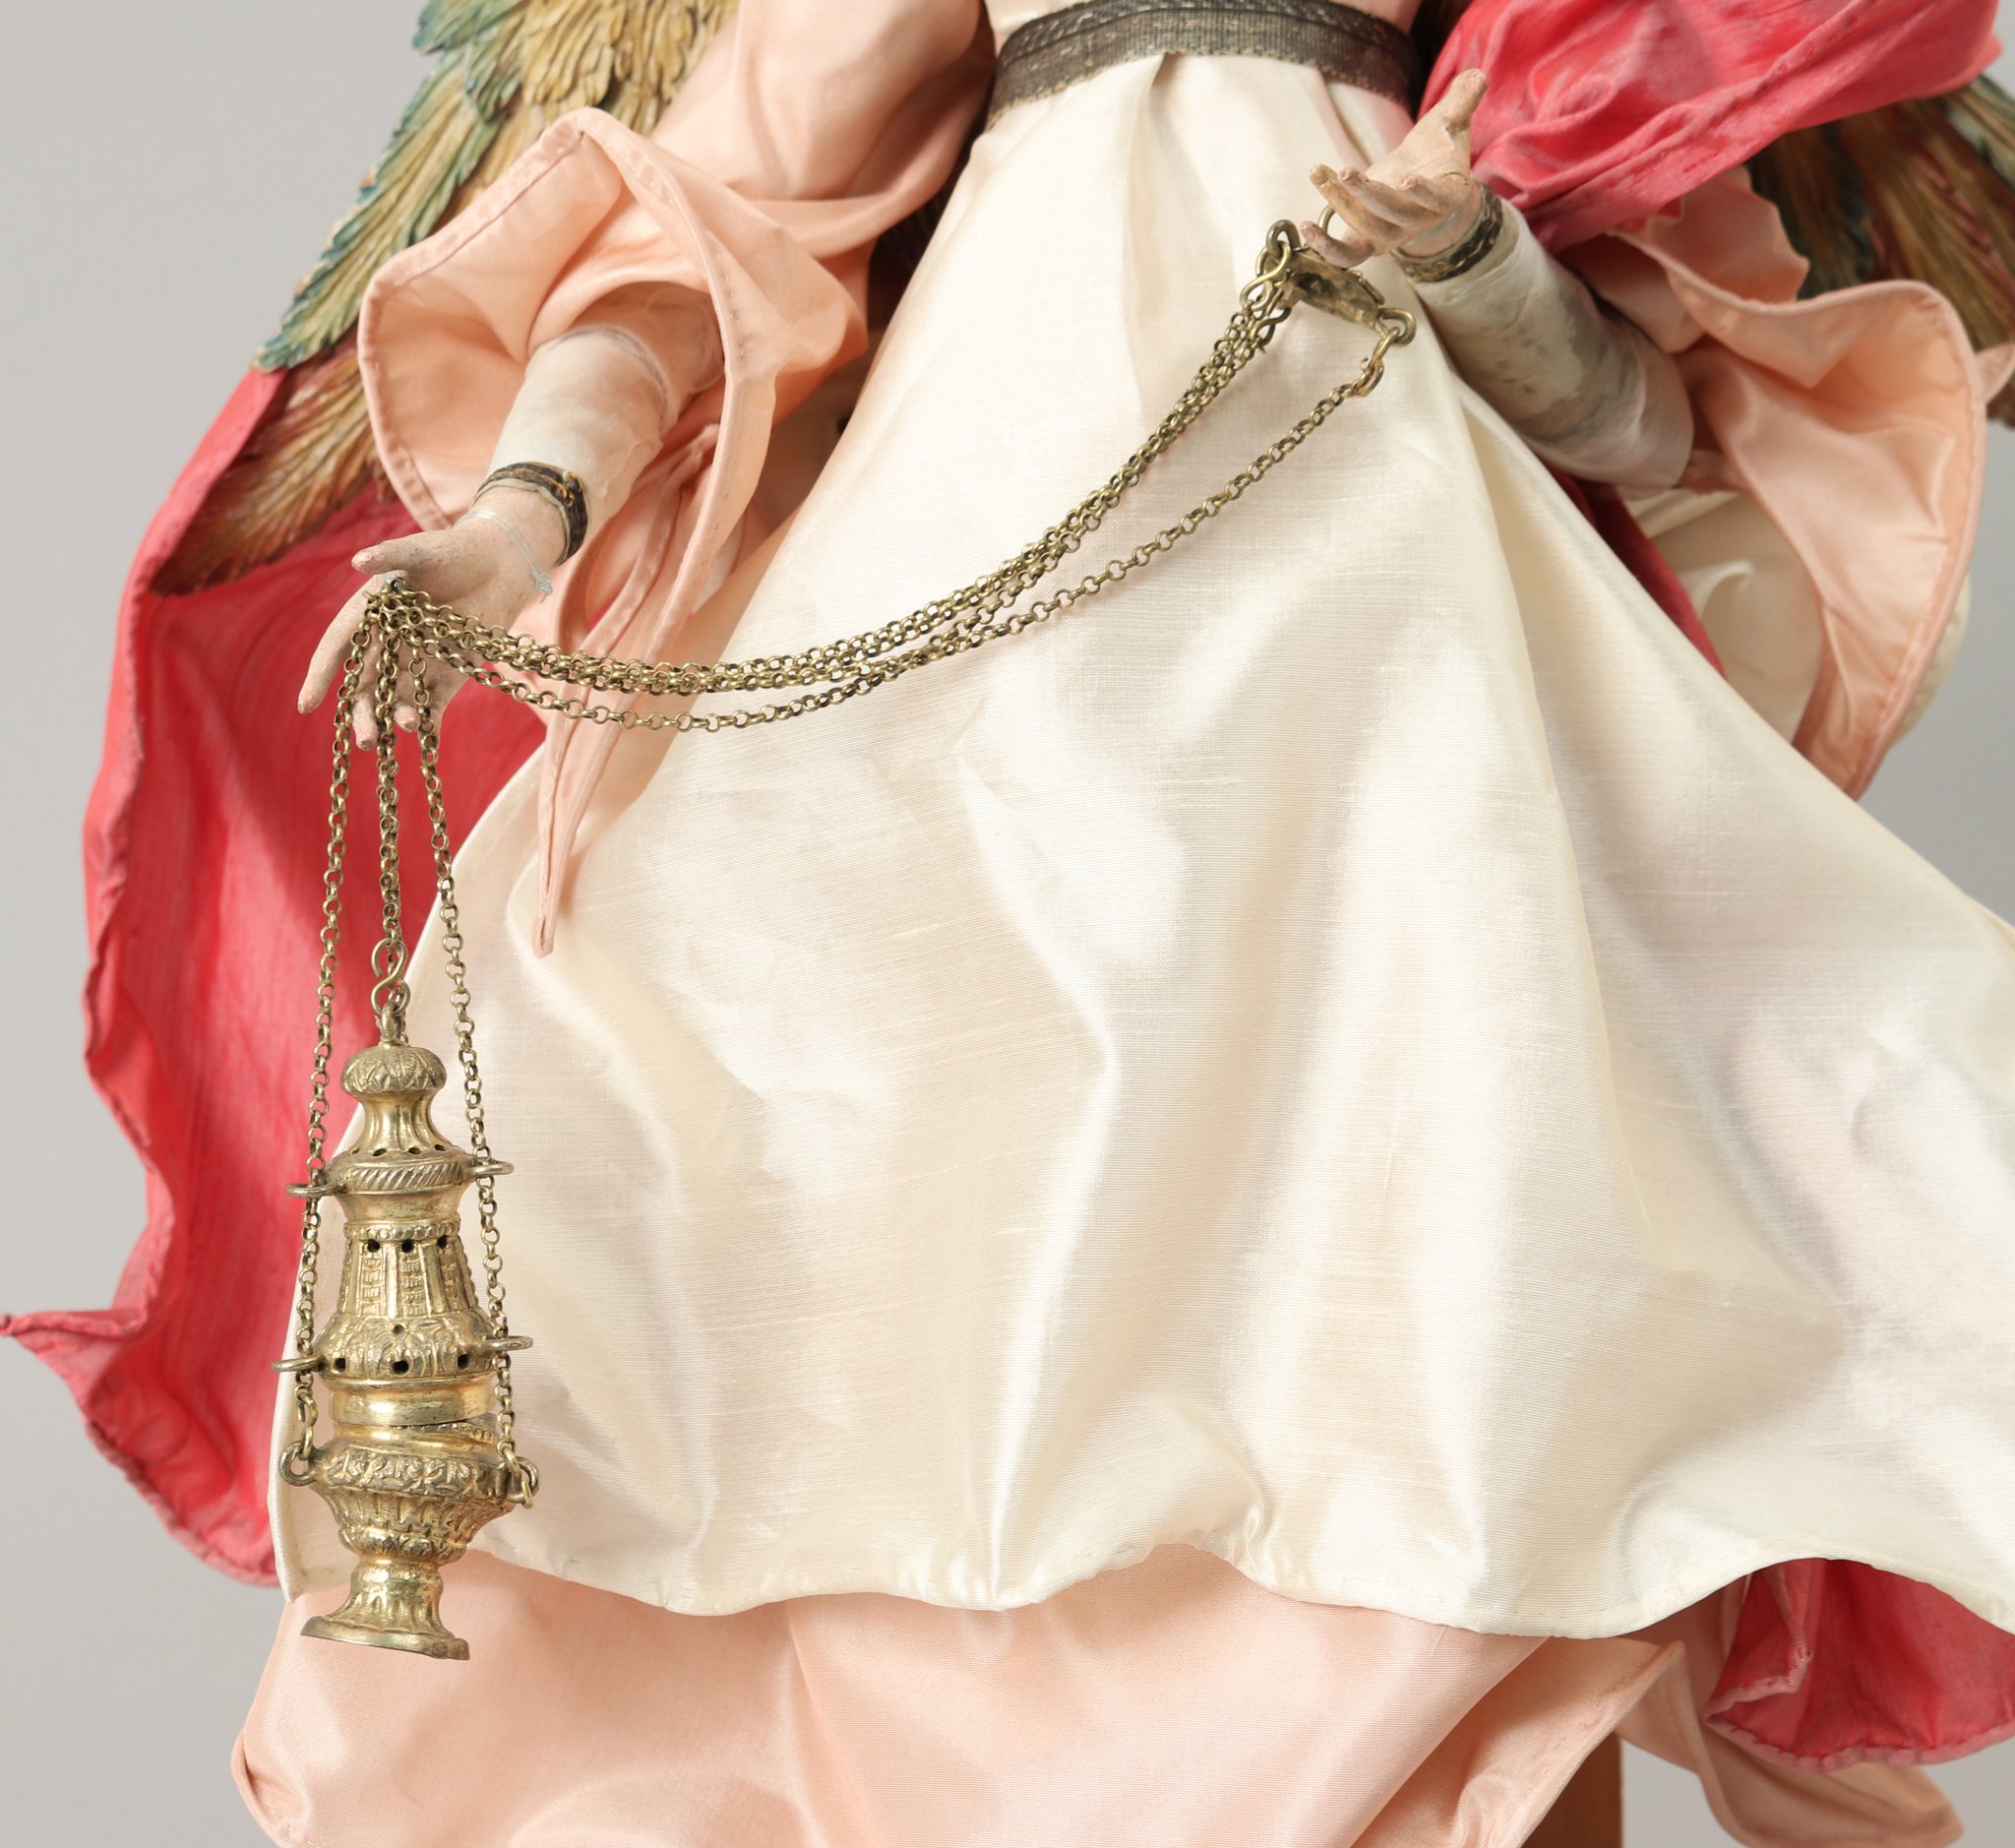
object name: crèche figure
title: Censer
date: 1701-1800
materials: silver gilt